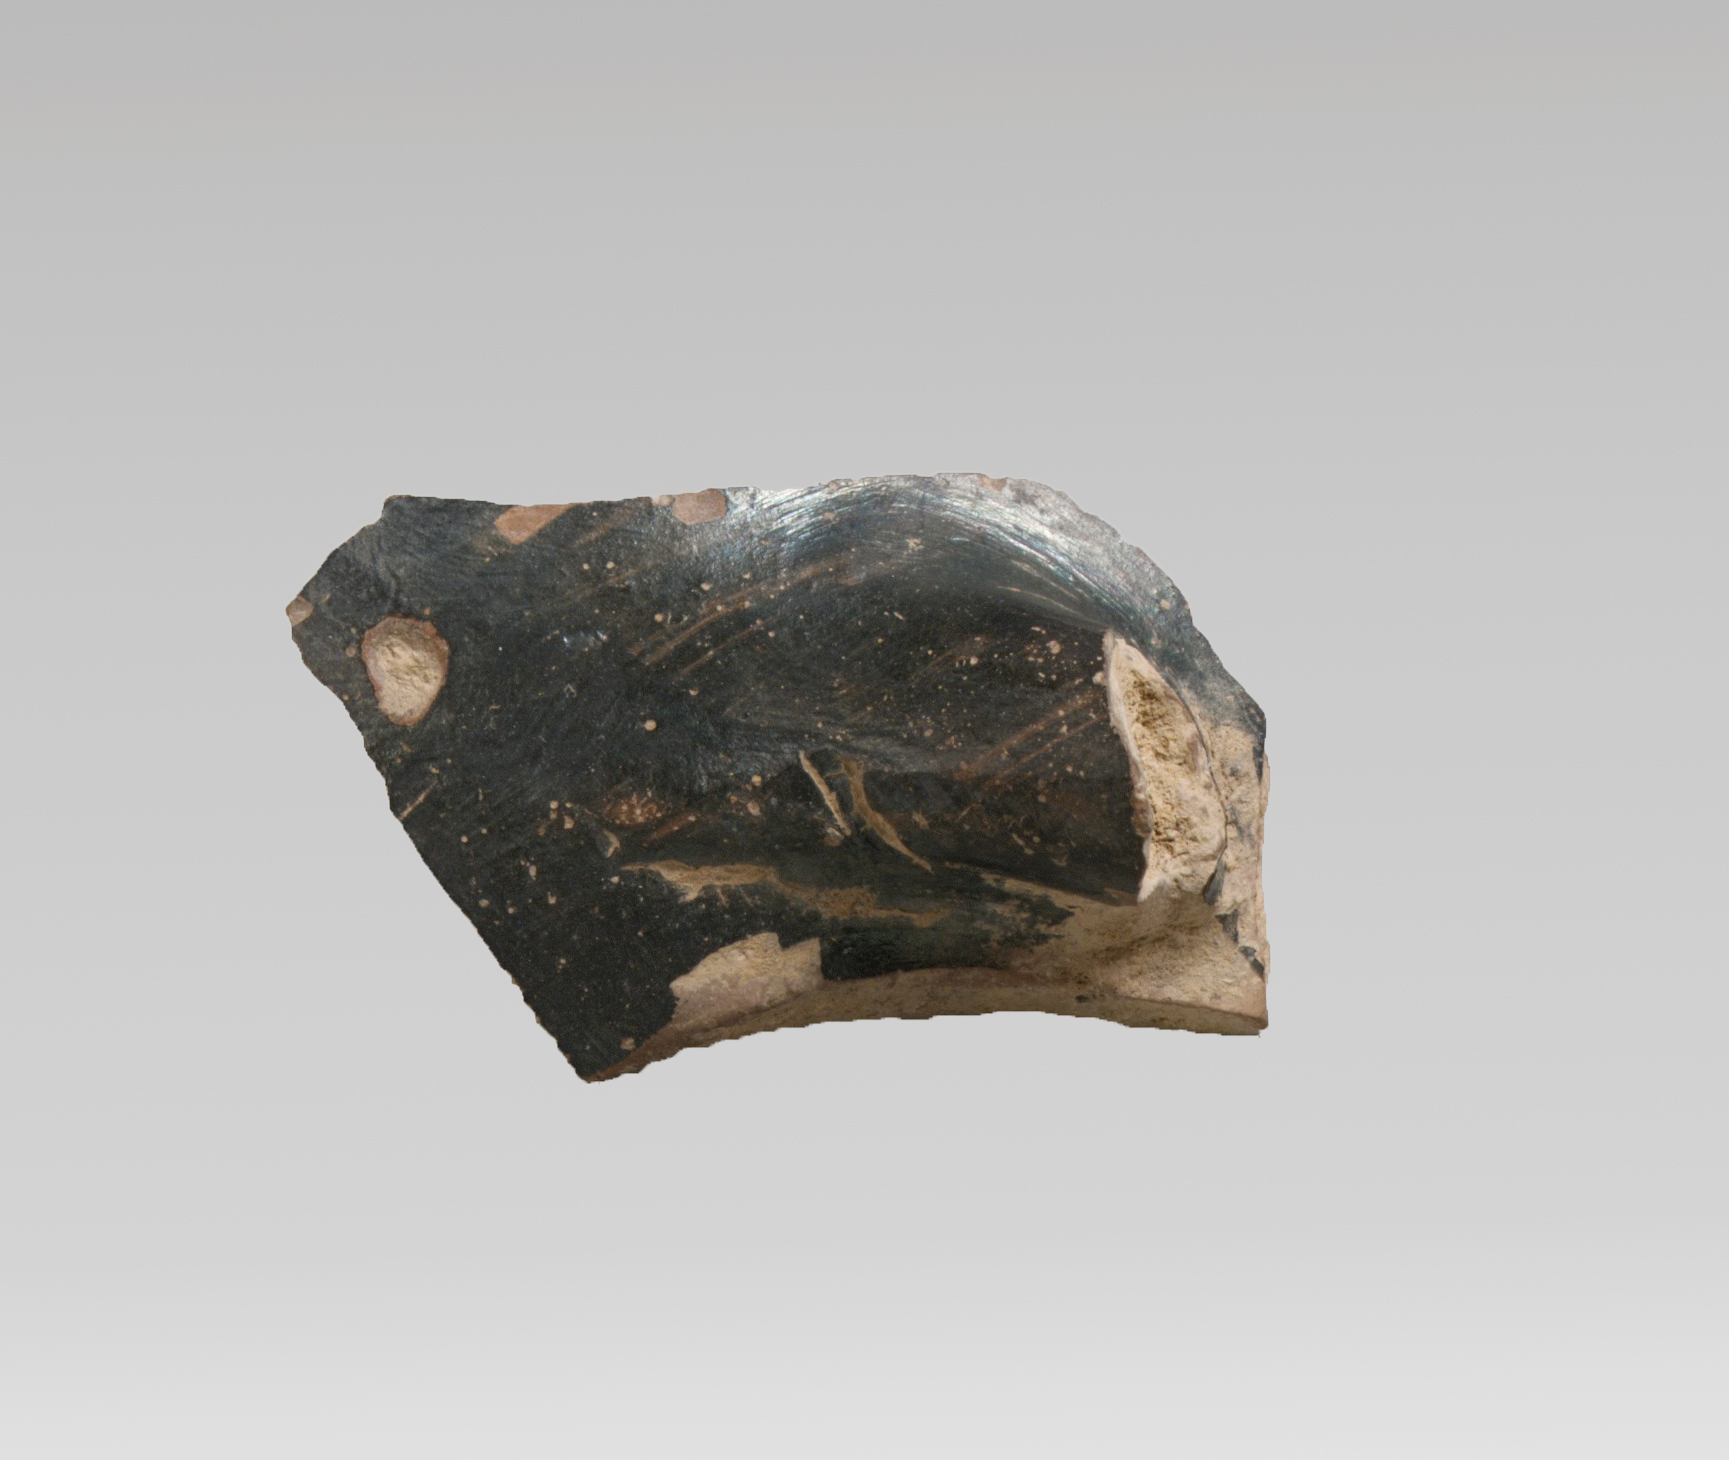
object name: vase fragment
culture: greek, laconian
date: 2000-1550 BCE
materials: terracotta